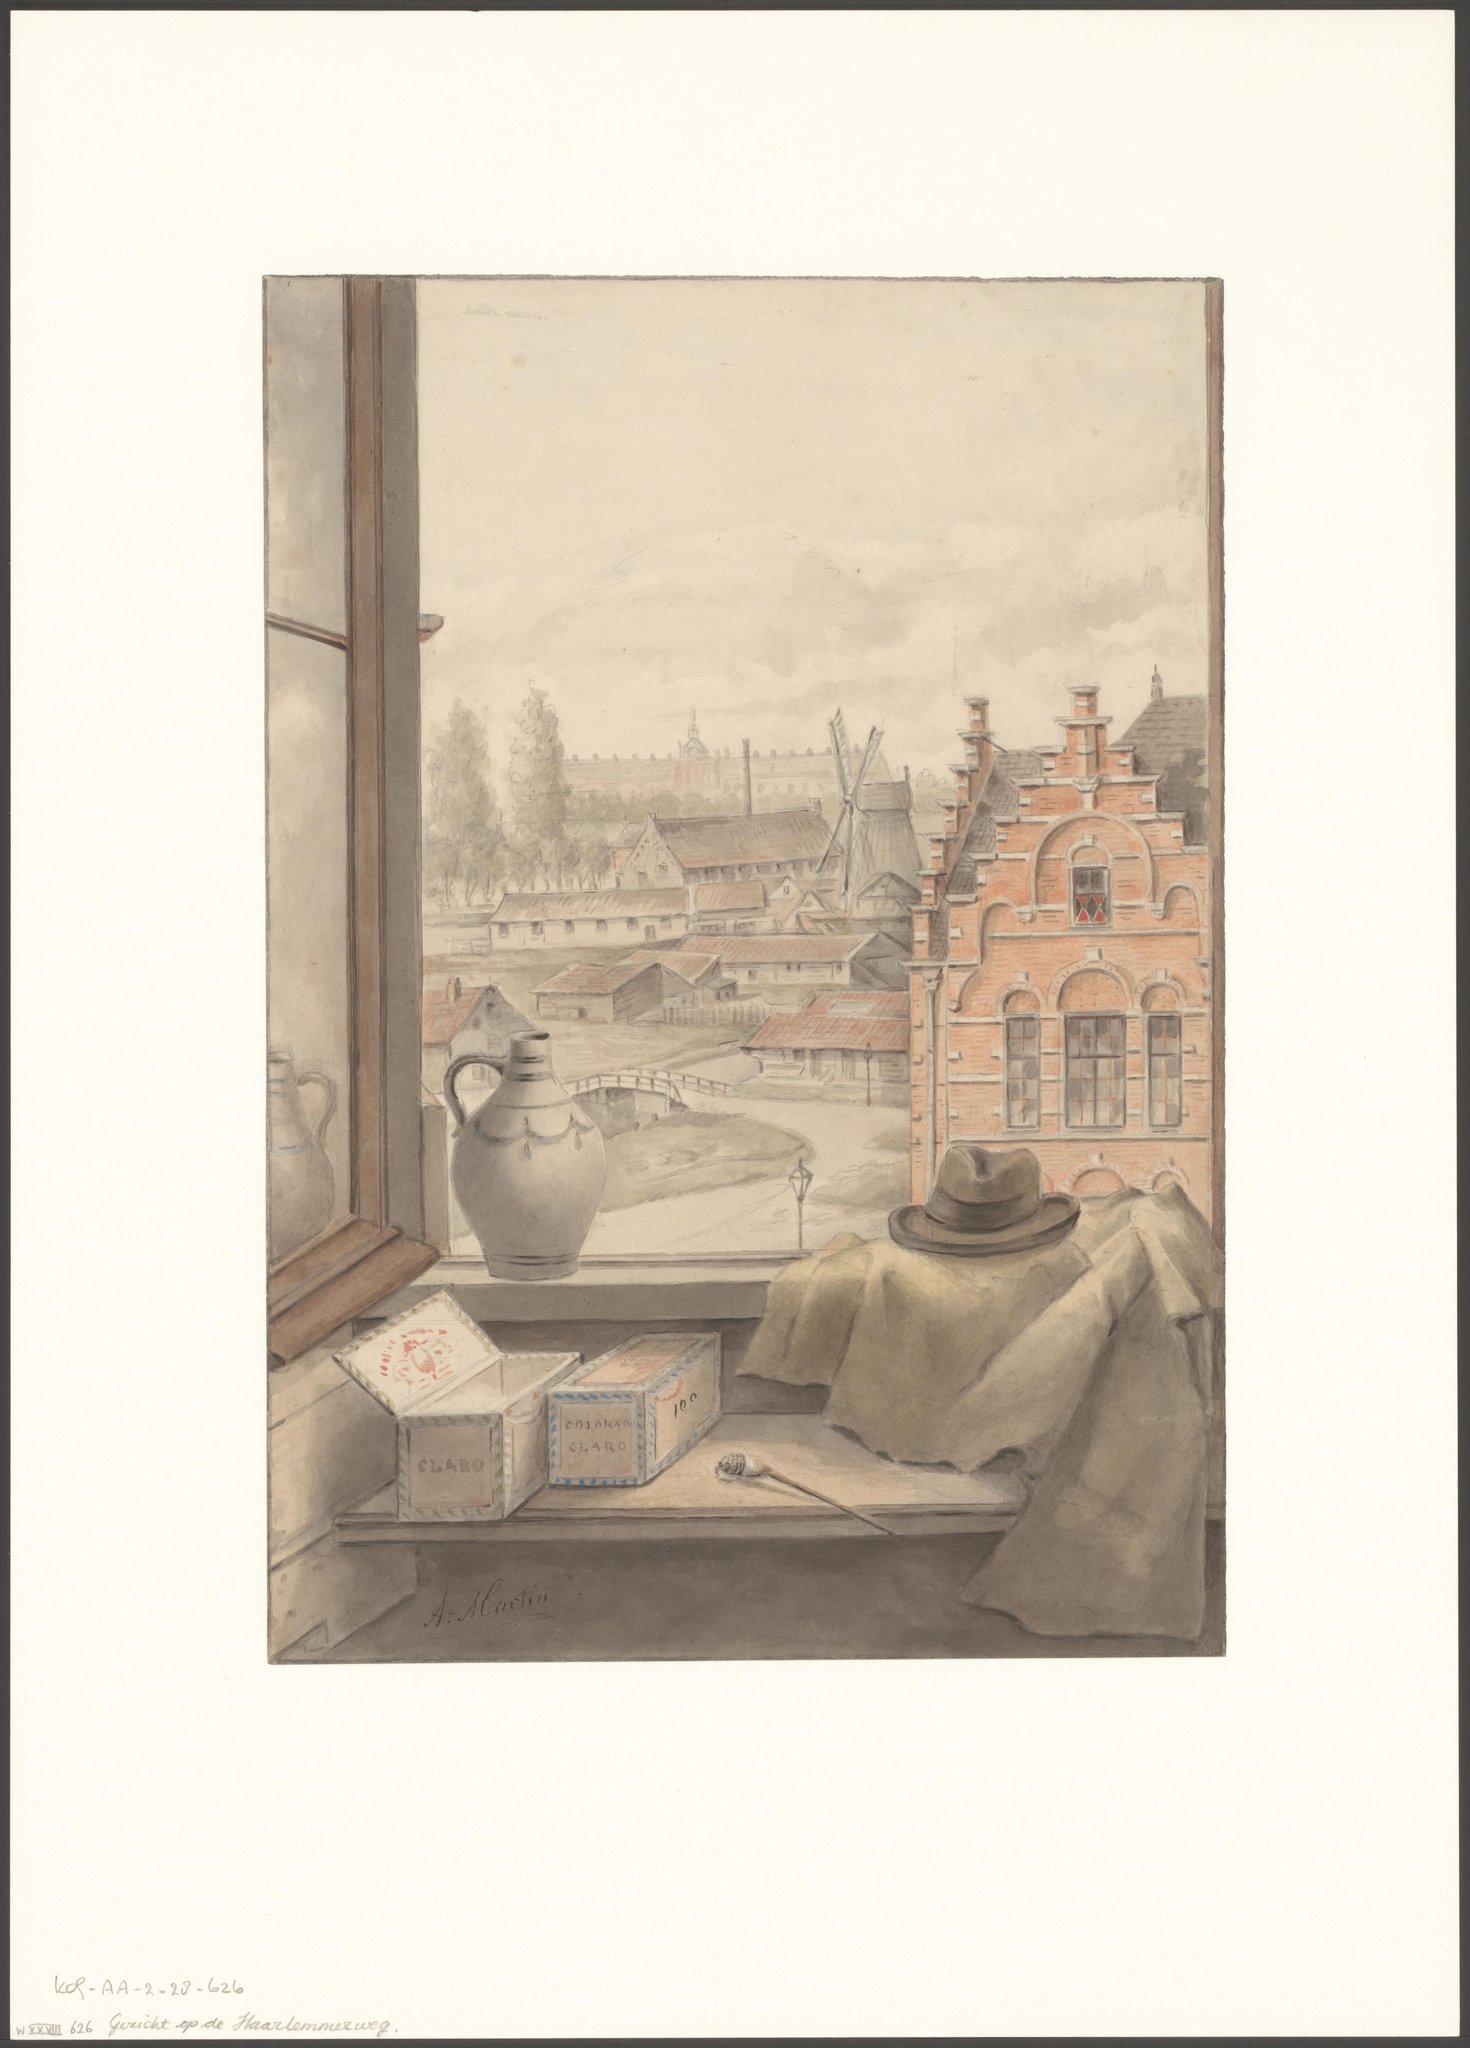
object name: drawing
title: Gezicht op de Haarlemmerweg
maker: albert martin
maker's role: draughtsman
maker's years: 1827-1900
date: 1837-1900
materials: paper, pencil, watercolor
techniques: brush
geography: amsterdam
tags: city-view in general; 'veduta', jar, jug (used as drinking-vessel), head-gear: hat, view through a window from the inside, windmill in landscape, street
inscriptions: signature: ‘A:Martin’, collector's mark: Lugt 800a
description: Tekening binnen de Atlas Van Eck ingedeeld op wijknummer 28.